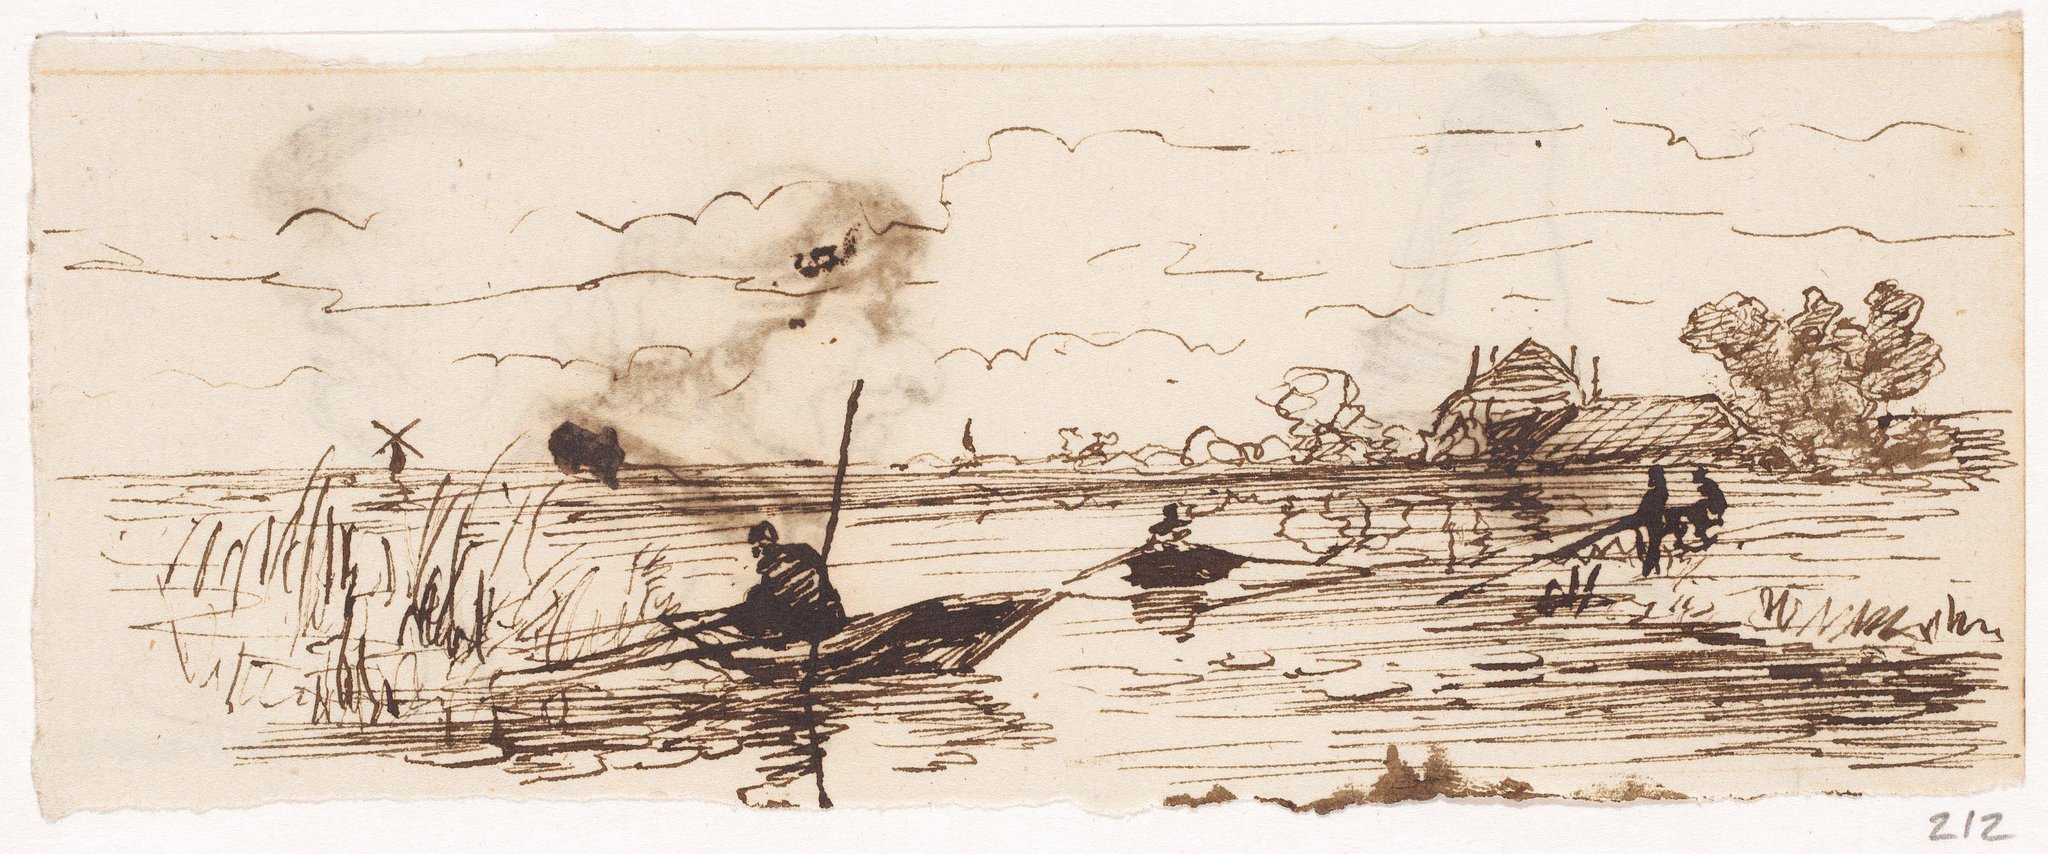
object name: drawing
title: Rivierlandschap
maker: johannes tavenraat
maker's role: draughtsman, painter, print maker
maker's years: 1809-1881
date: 1840-1880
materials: ink, paper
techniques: pen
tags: river (+ landscape with figures, staffage), angling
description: Rivierlandschap met vissers in roeiboten tussen het riet.